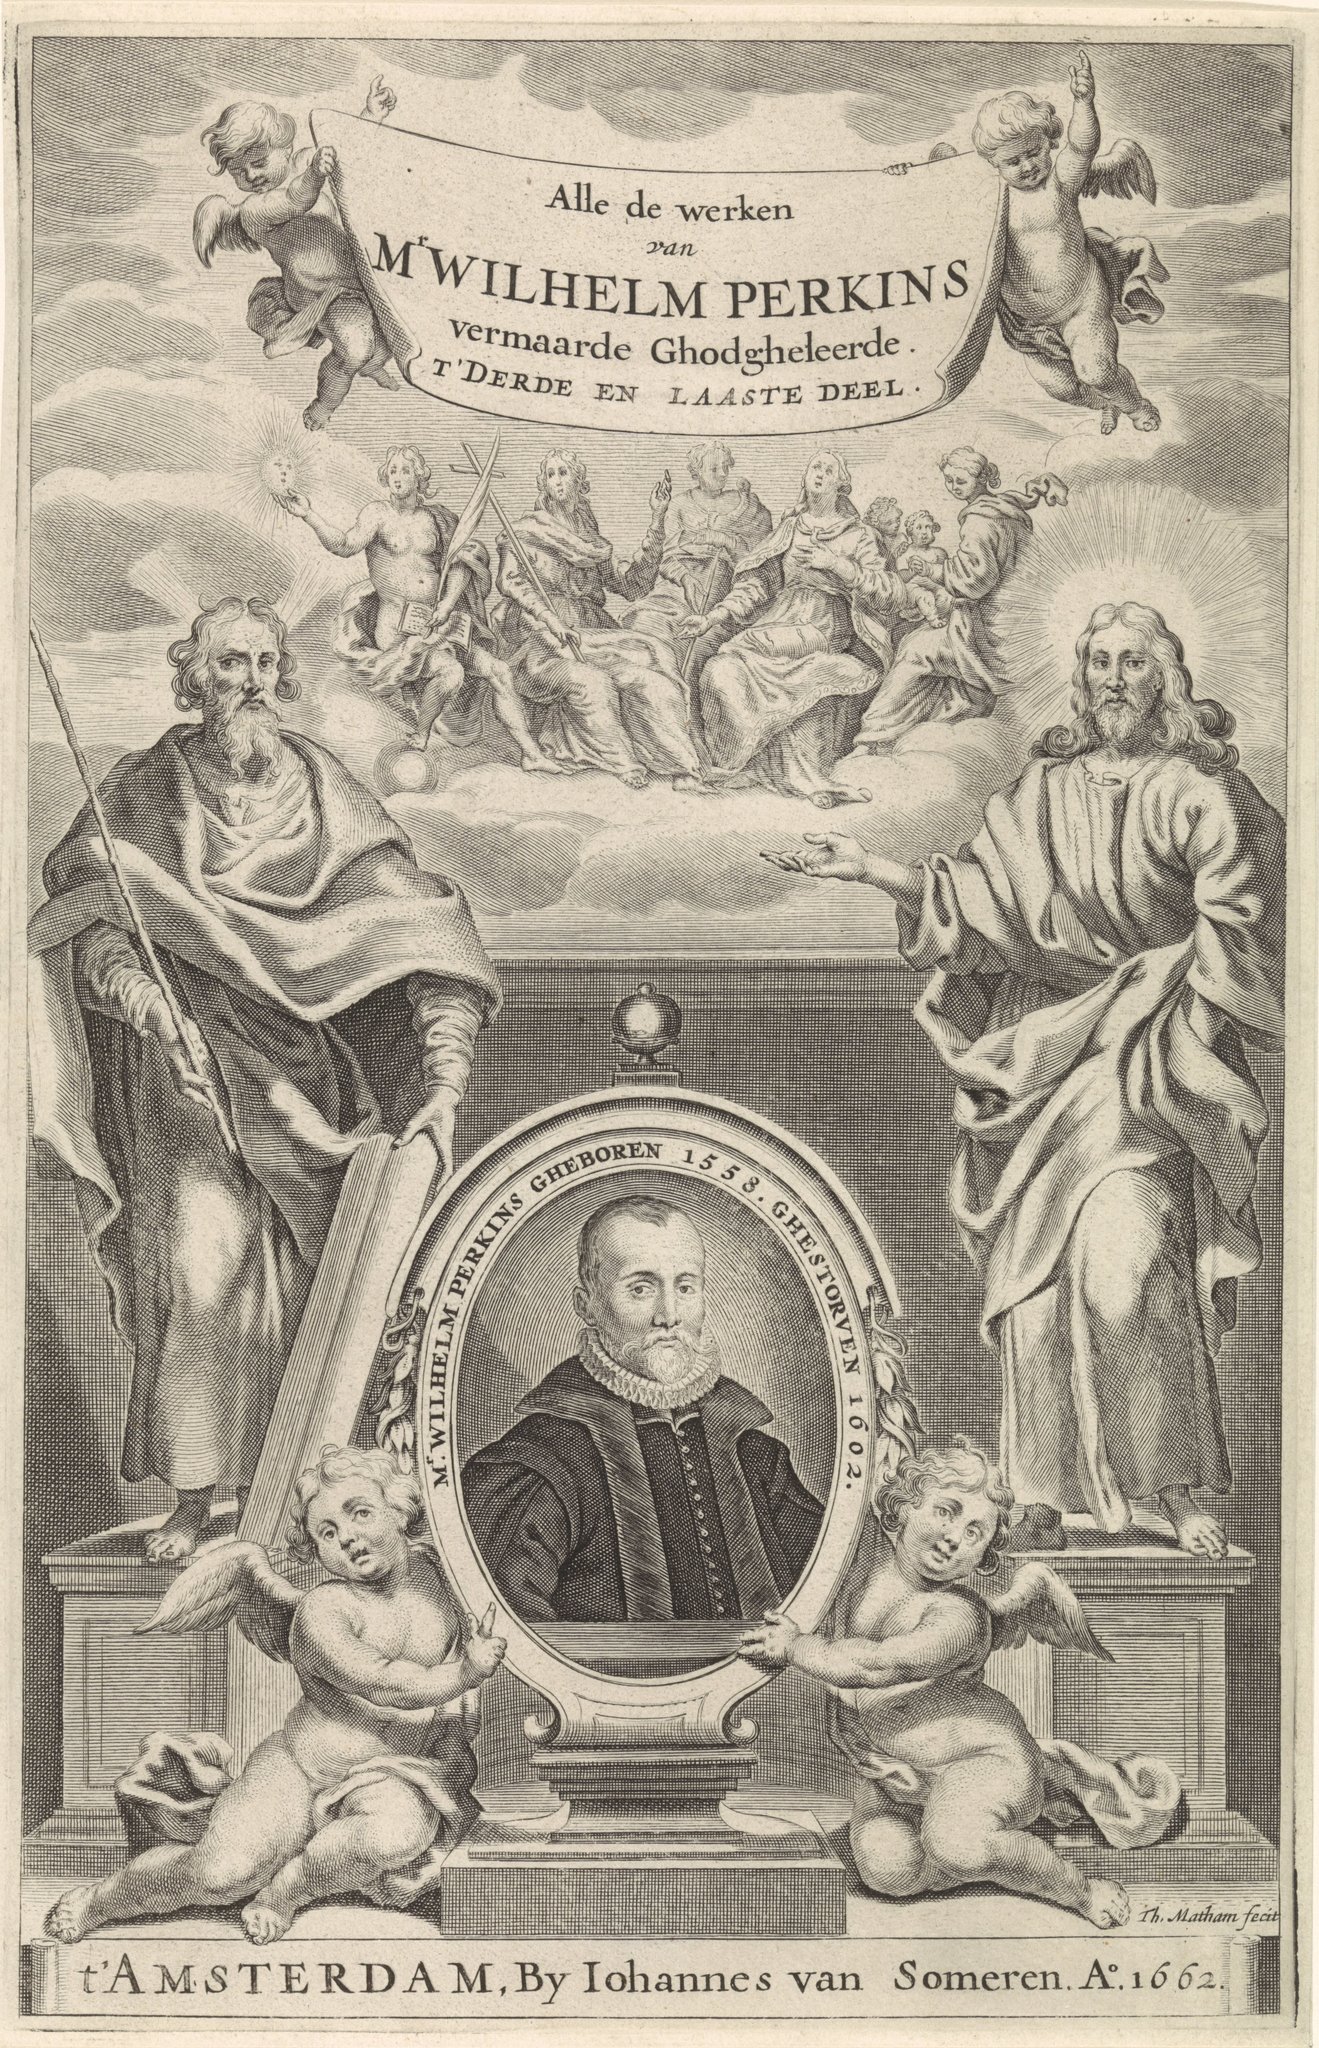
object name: titelblad, titelpagina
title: Titelpagina voor: W. Perkins, Alle de werken, deel 2, 1662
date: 1662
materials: paper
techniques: engraving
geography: amsterdam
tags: the three theological virtues, moses (not in biblical context); possible attributes: rays of light or horns on his head, rod, tables of the law, angel(s) represented as child(ren), 'portraits' of christ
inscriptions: collector's mark: Lugt 2228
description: Portret van William Perkins in een ovaal cartouche dat wordt vastgehouden door twee putti. Rechts van het portret Christus en links Mozes. Bovenaan houden twee putti een banderol vast met de titel, waarop: derde en laatste deel. Daaronder enkele figuren op een wolkendek, waaronder de drie theologische deugden geloof, hoop en liefde.